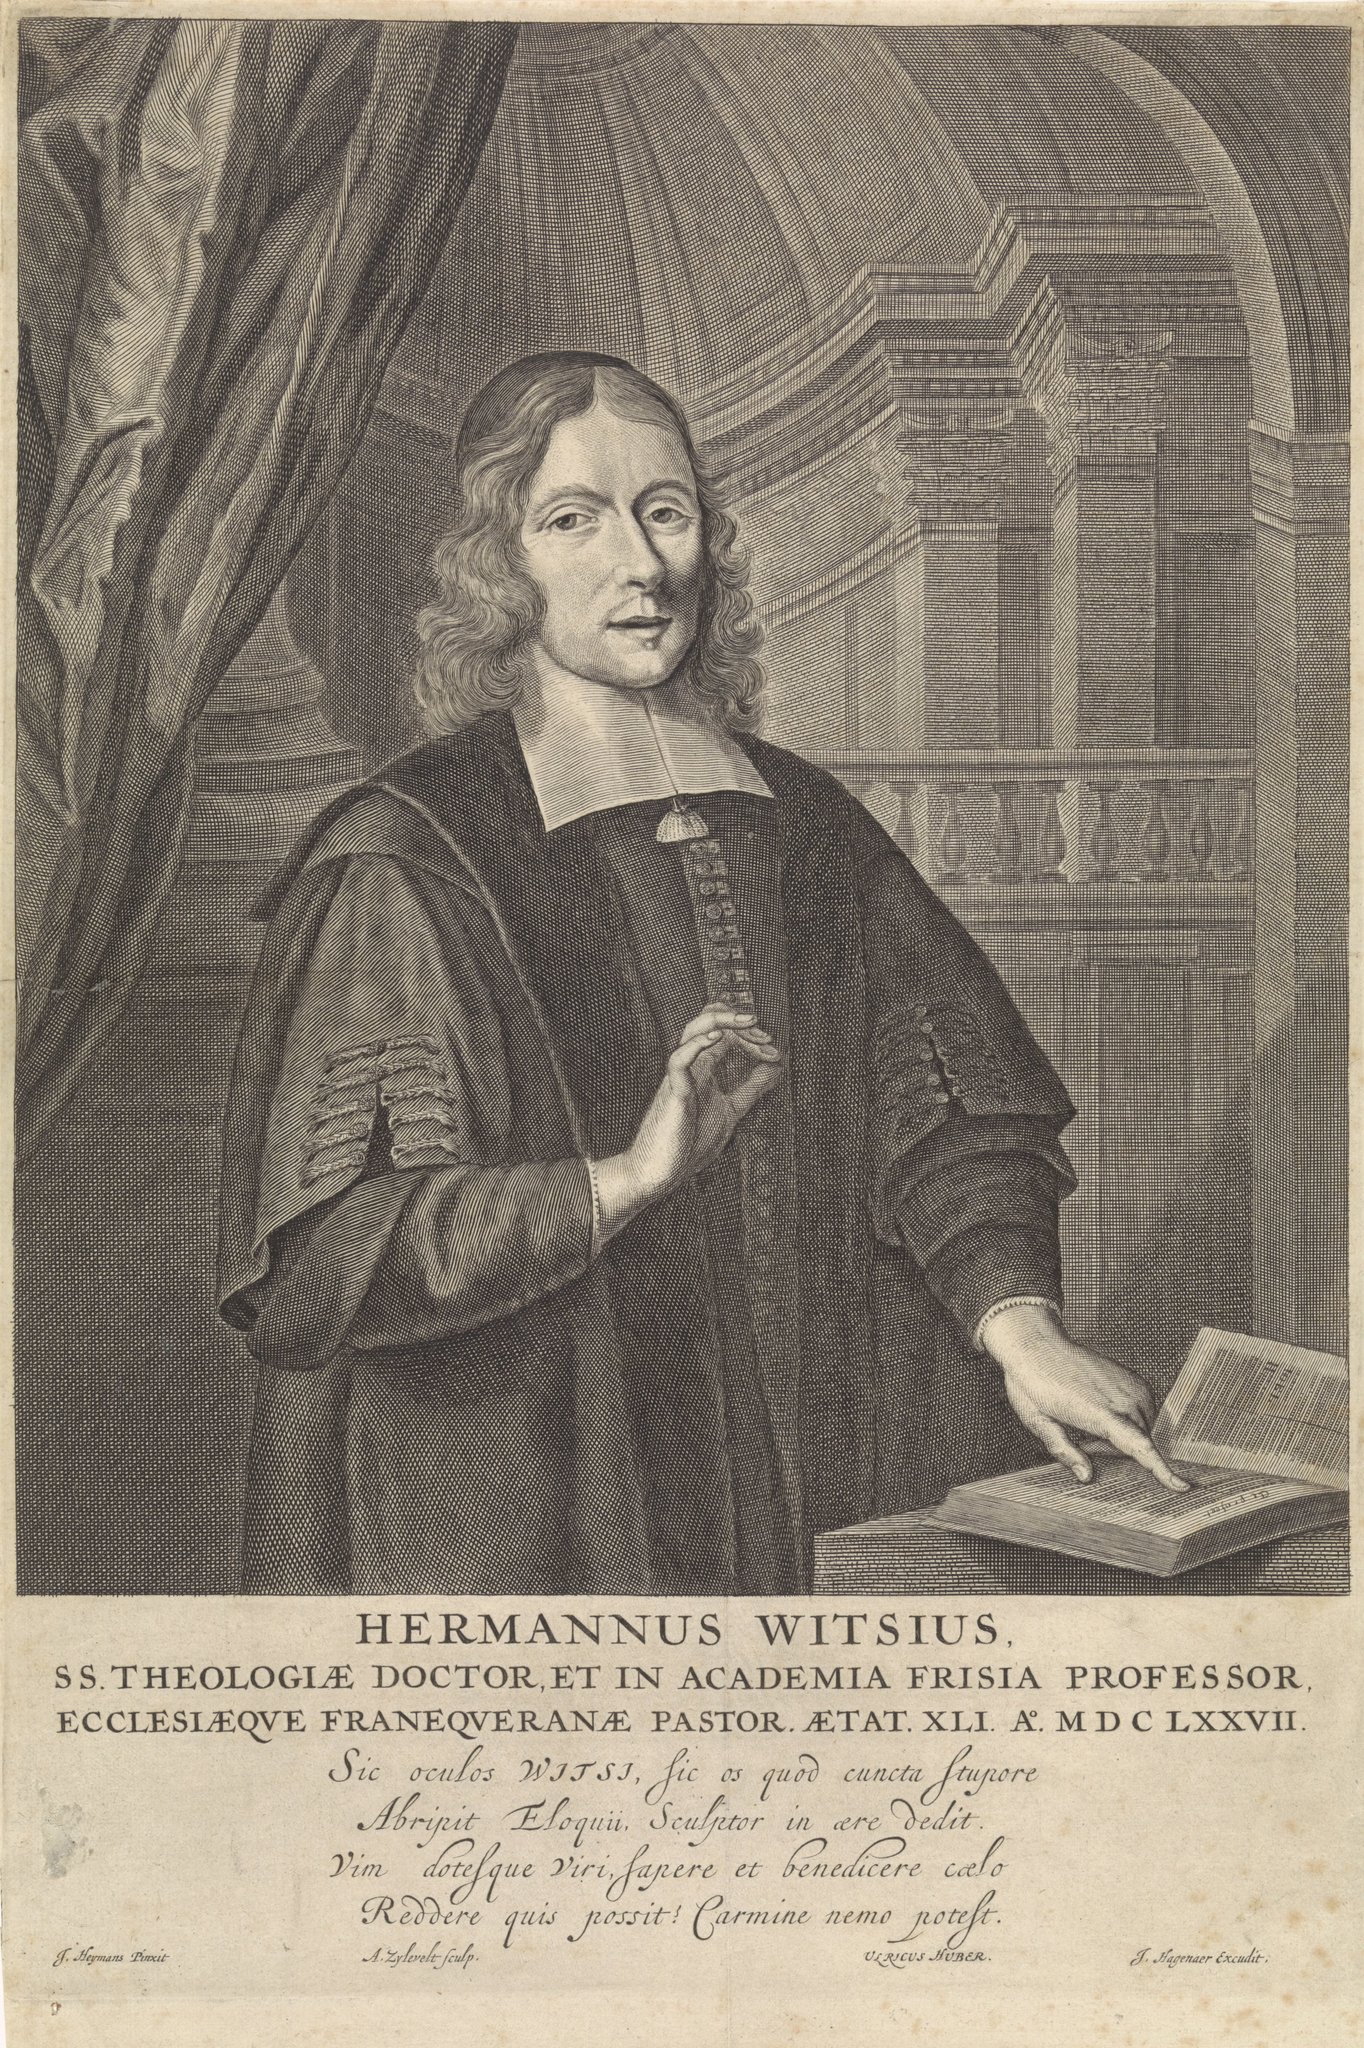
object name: print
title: Portret van Herman Witsius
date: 1675-1679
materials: paper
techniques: engraving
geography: amsterdam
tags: enkhuizen, leiden, herman witsius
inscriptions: collector's mark: Lugt 2228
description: Portret van Herman Witsius, predikant en hoogleraar theologie te Franeker, staande in een kerk bij een opengeslagen bijbel. Onderaan in de marge een vierreglig vers in het Latijn.